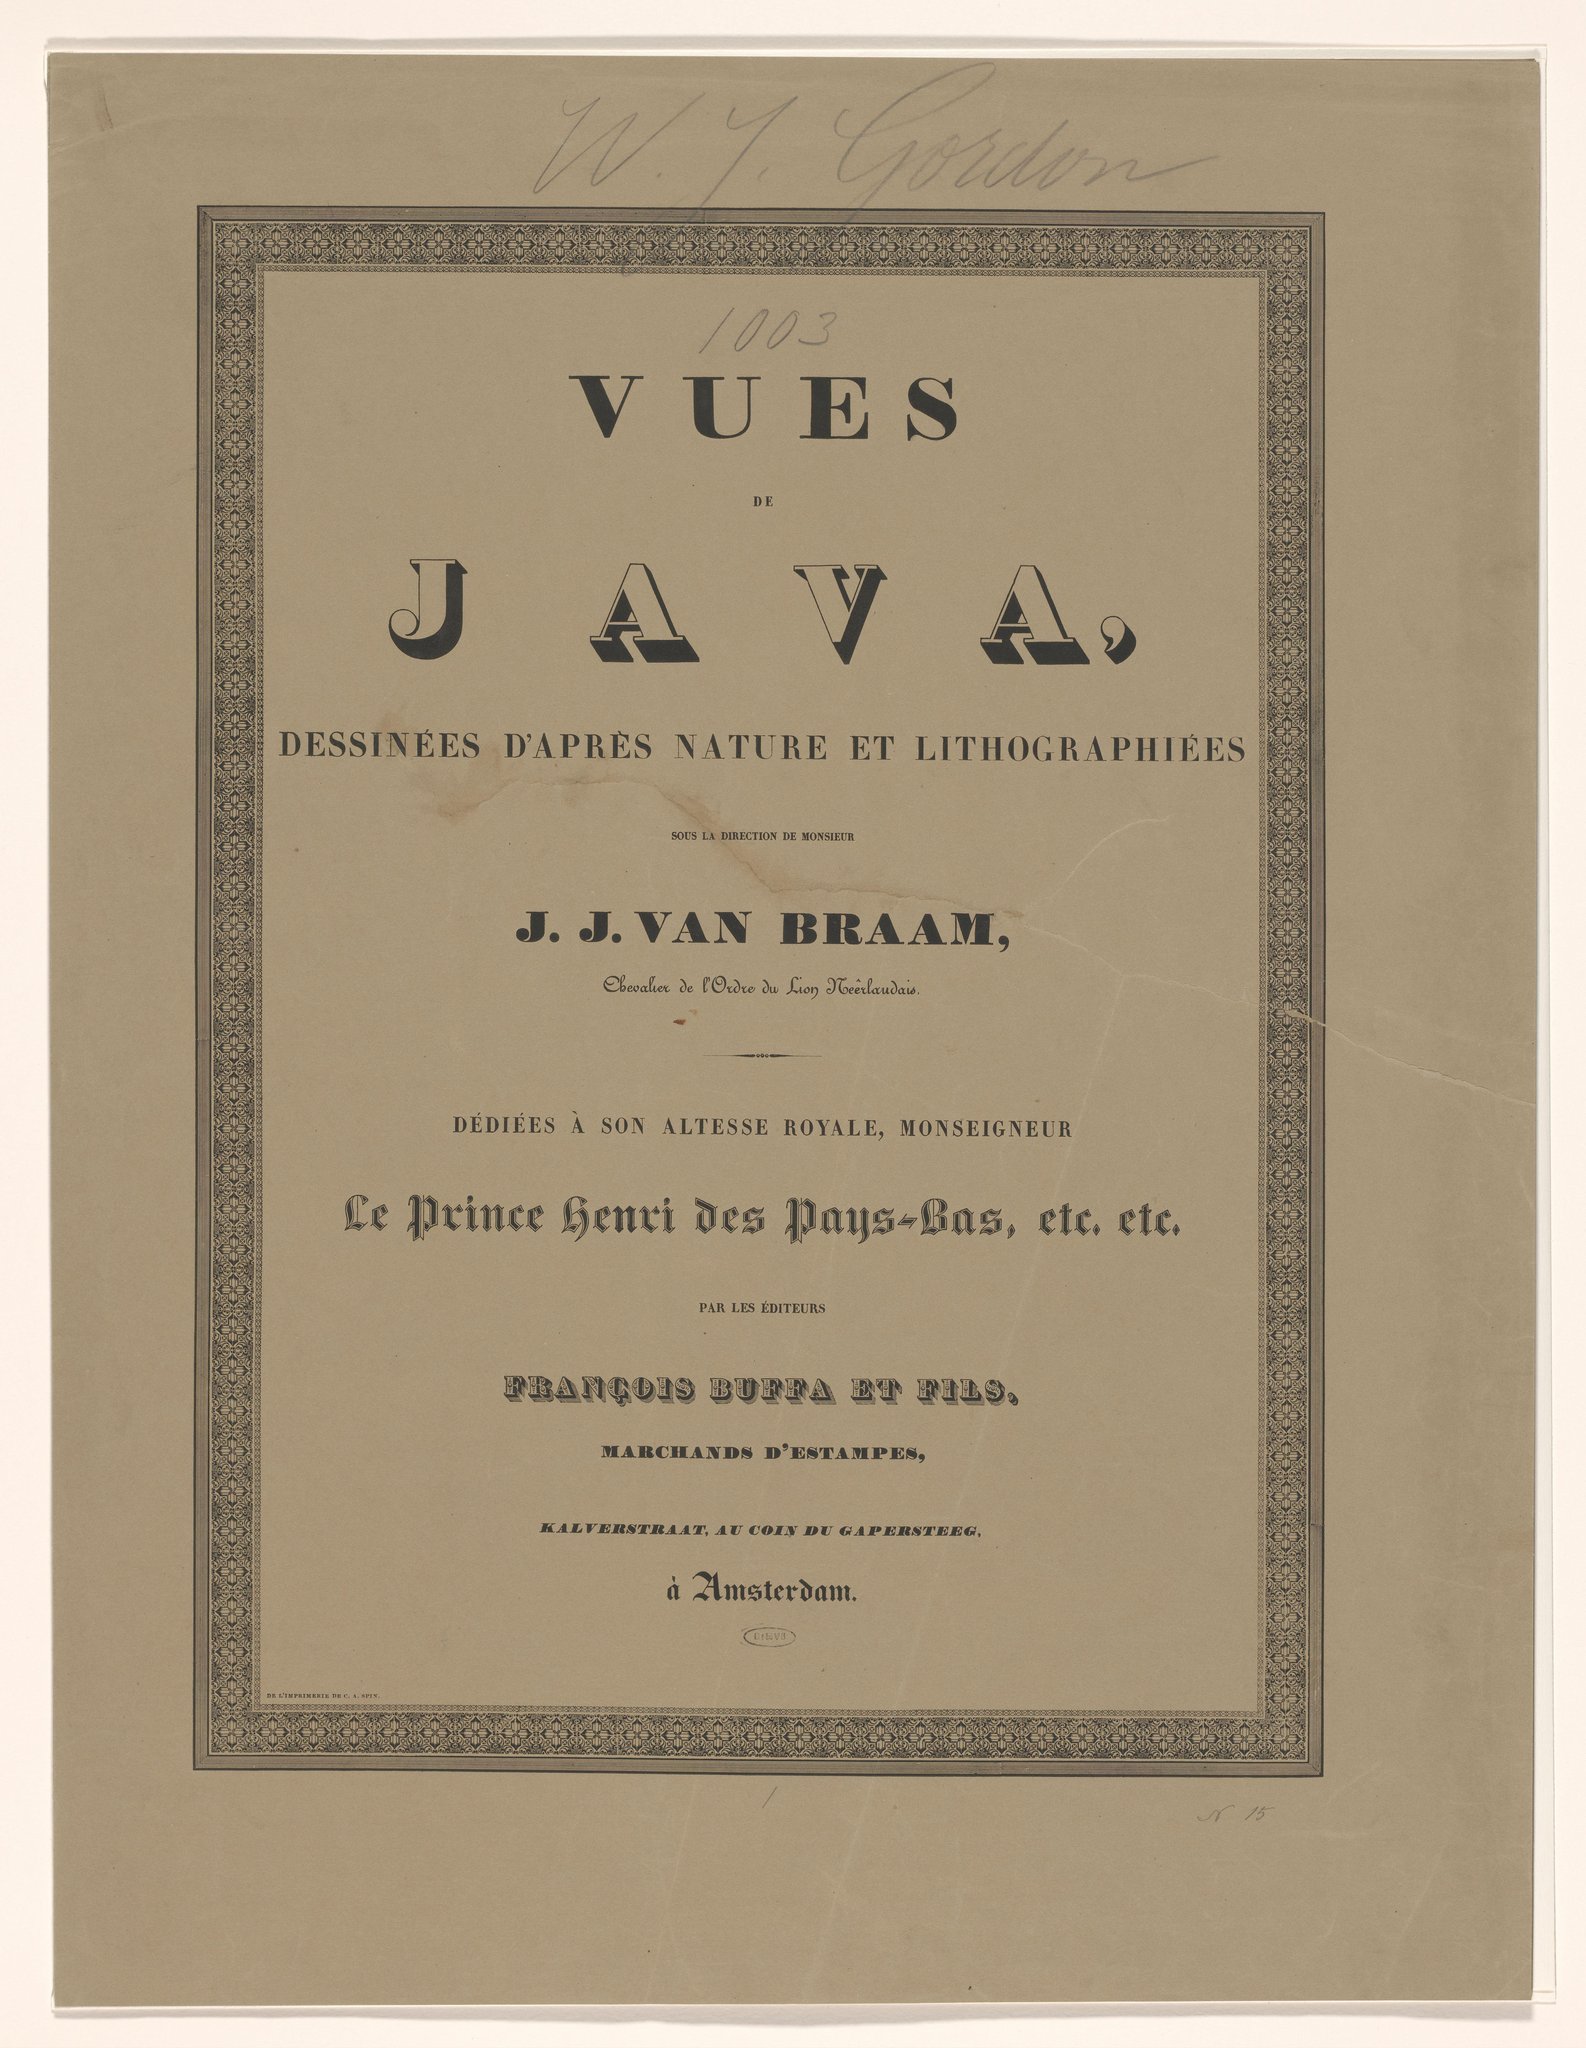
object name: print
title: Omslag voor een serie gezichten te Java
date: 1842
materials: paper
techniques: lithograph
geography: amsterdam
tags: city-view in general; 'veduta', java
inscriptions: collector's mark: Lugt 2228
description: Omslag voor een serie van zes lithografieën van gezichten te Java van Willem Jan Gordon.